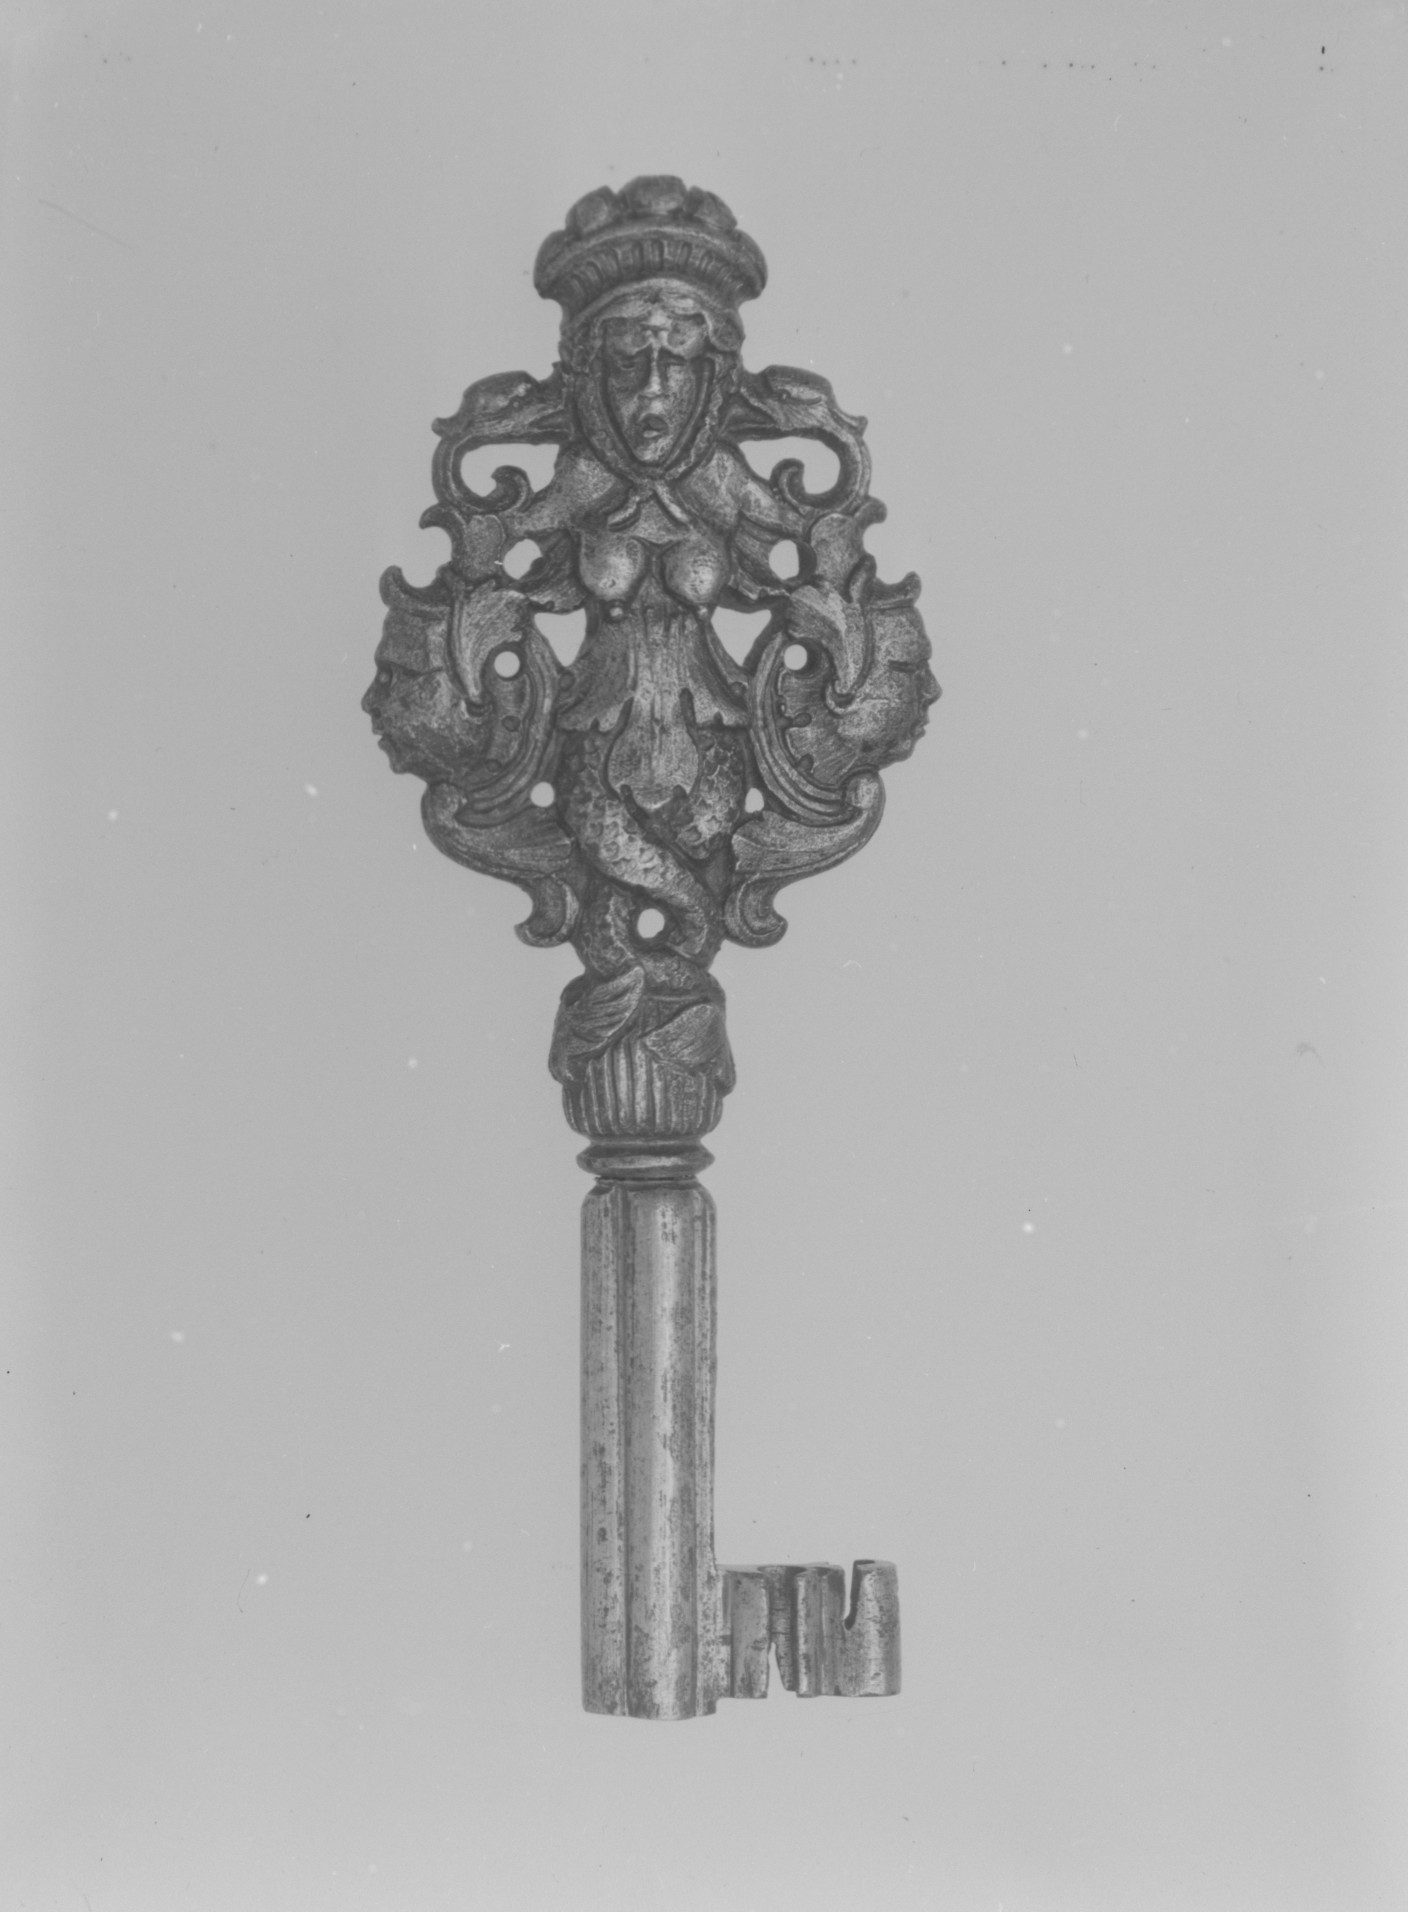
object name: key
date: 1501-1600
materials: iron